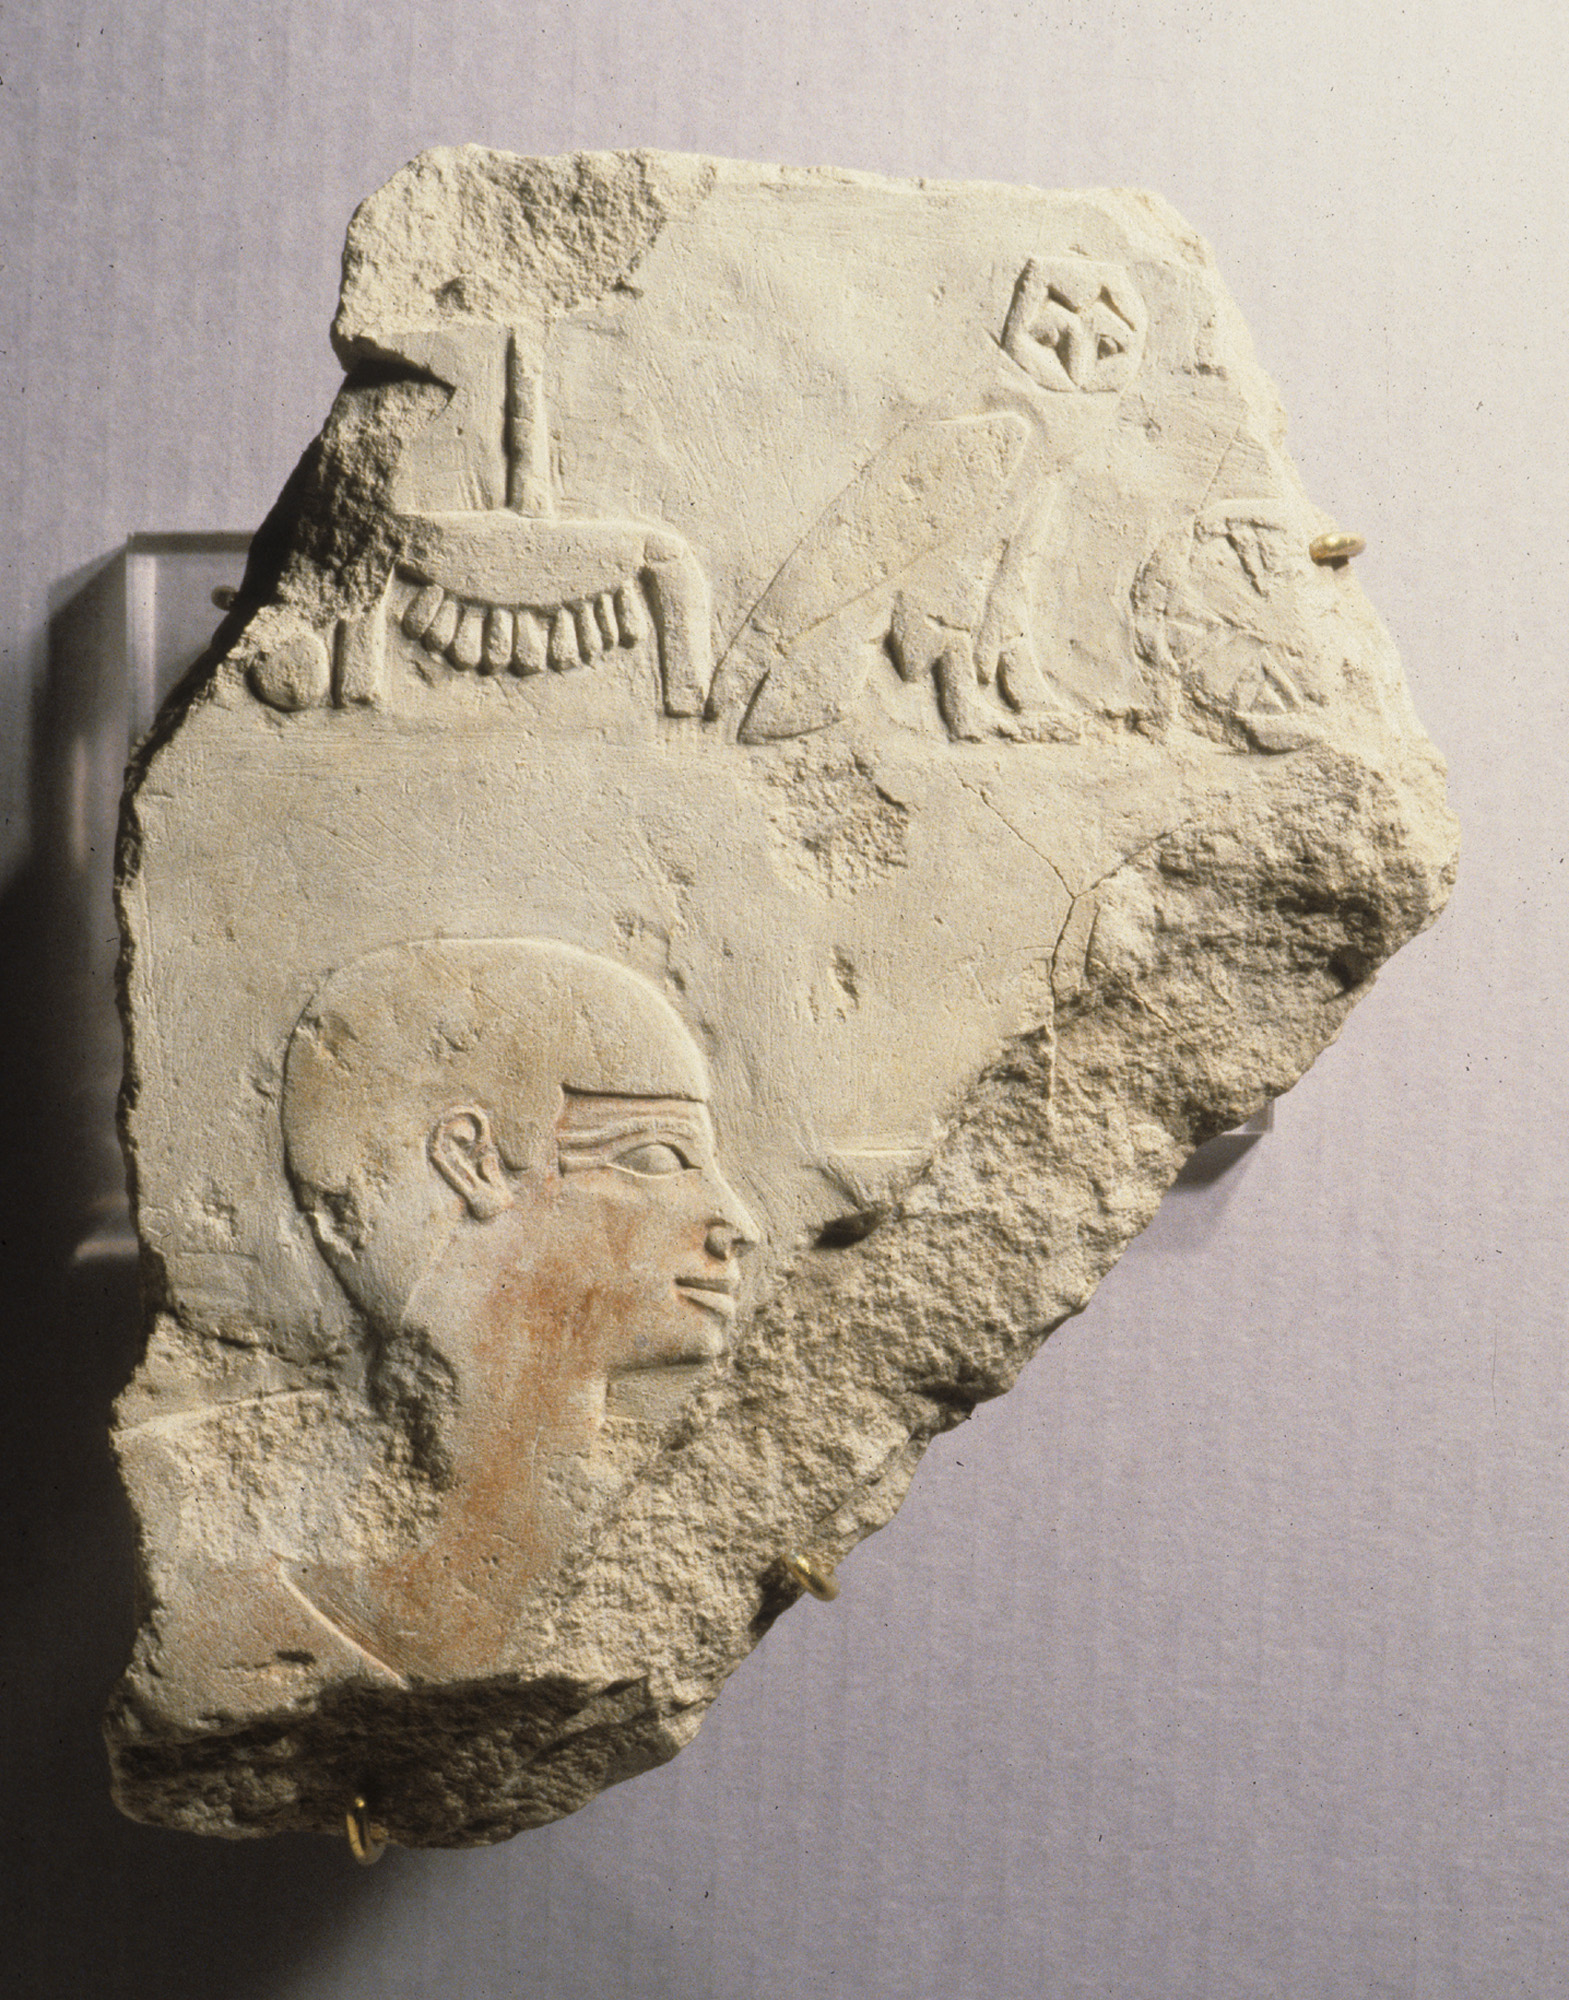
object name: relief, man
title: Relief Fragment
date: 1479-1458 BCE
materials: limestone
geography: upper egypt, thebes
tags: men,owls